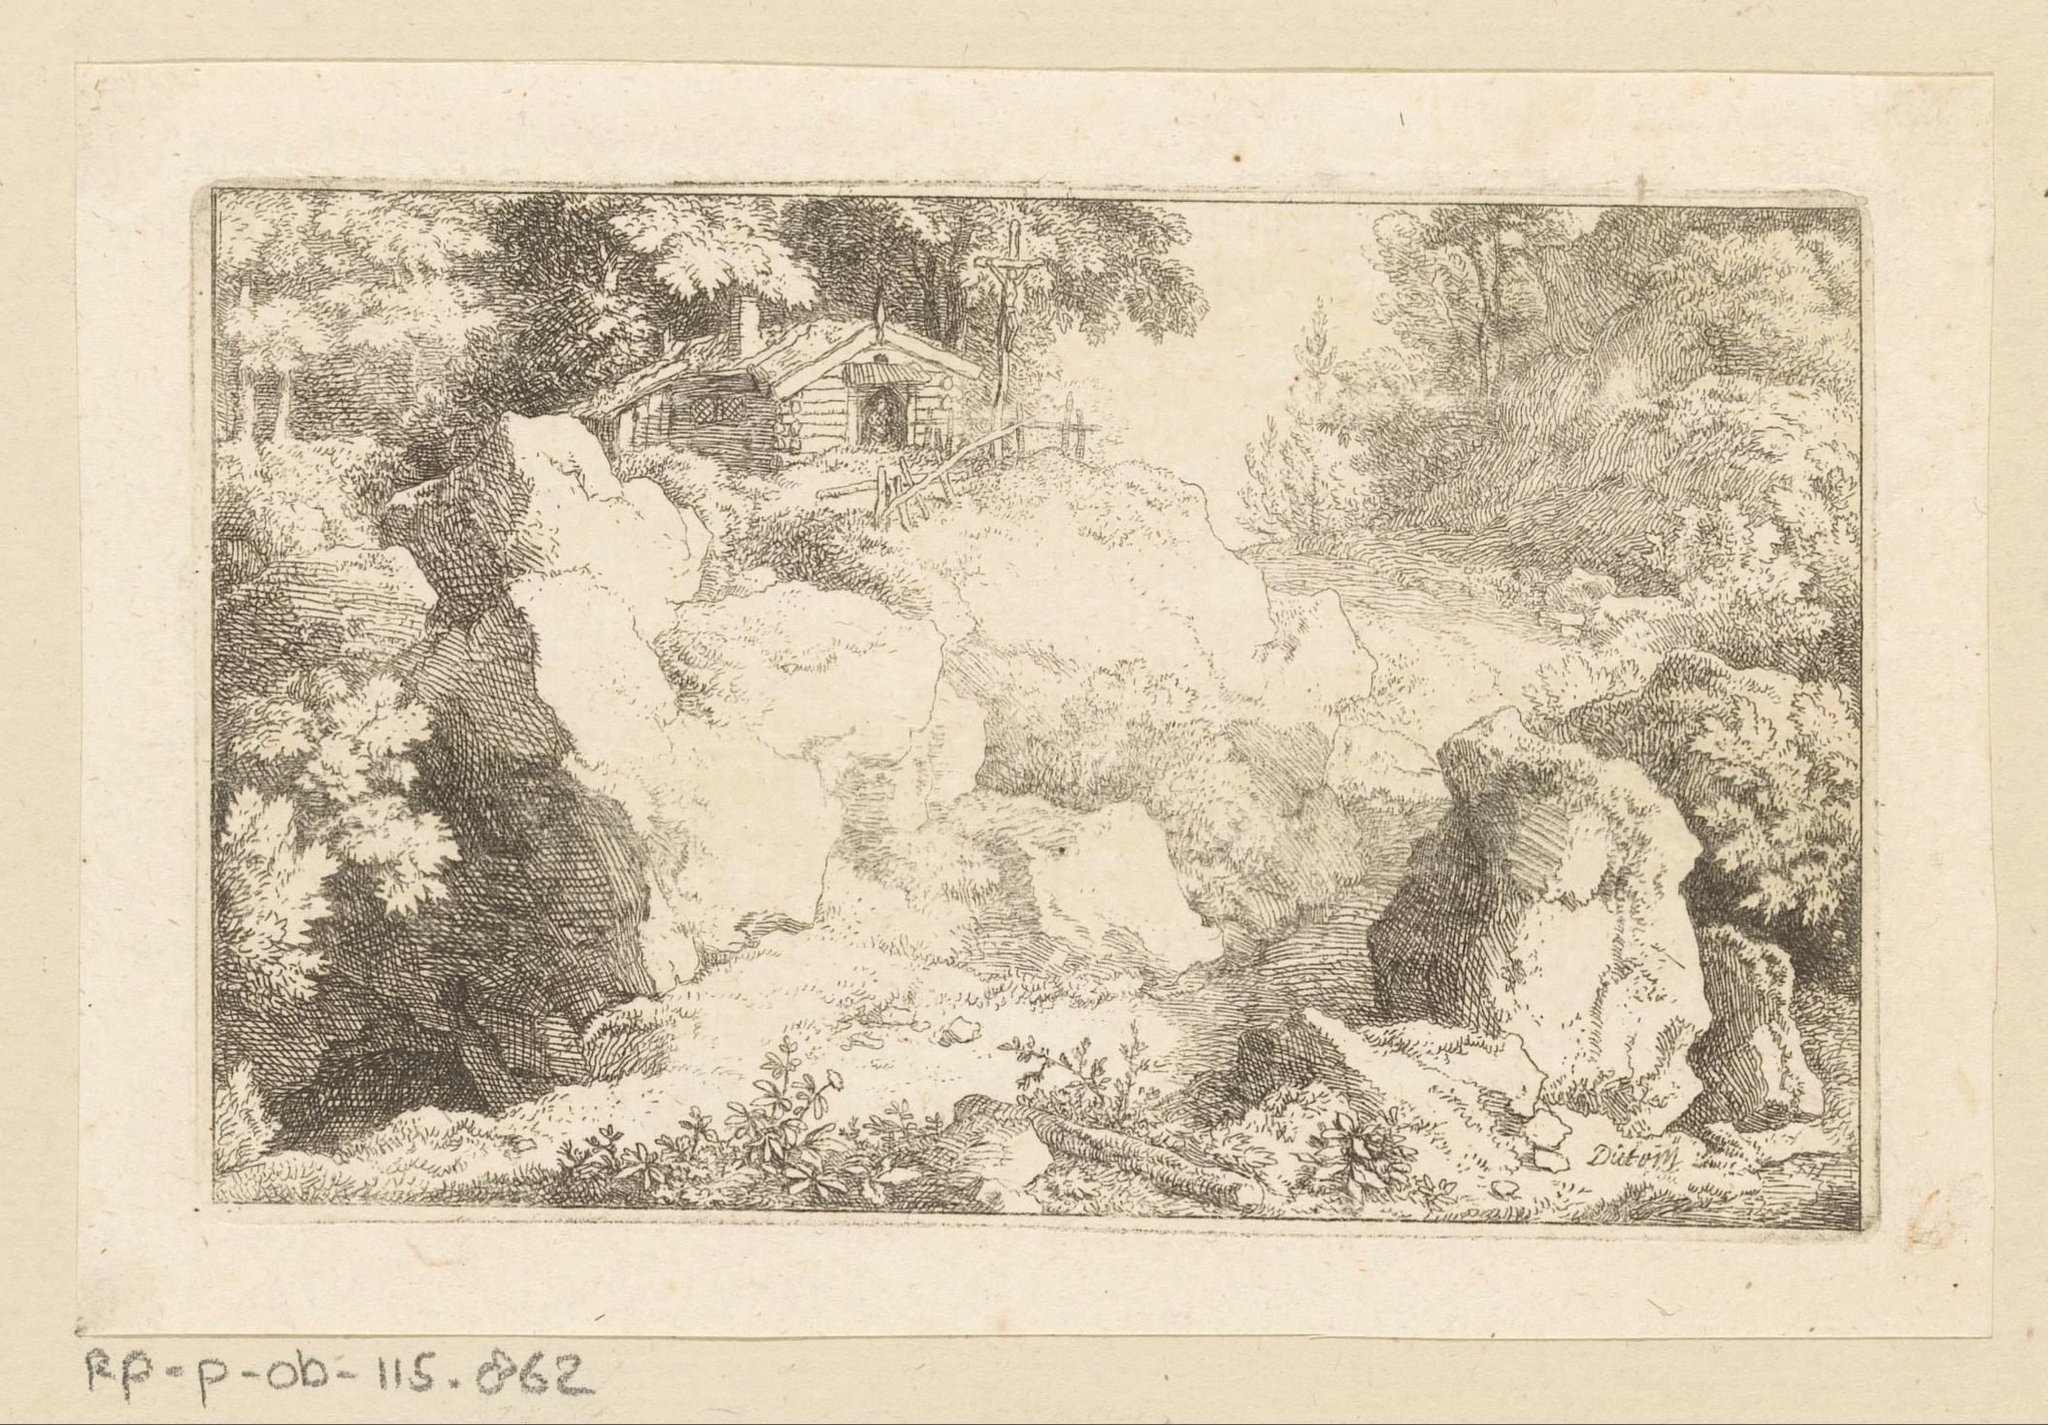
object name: print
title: Rotslandschap met berghut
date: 1722-1774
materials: paper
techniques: etching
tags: landscapes, hut, cabin, lodge, rocks - hh - ideal landscapes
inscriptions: collector's mark: Lugt 240